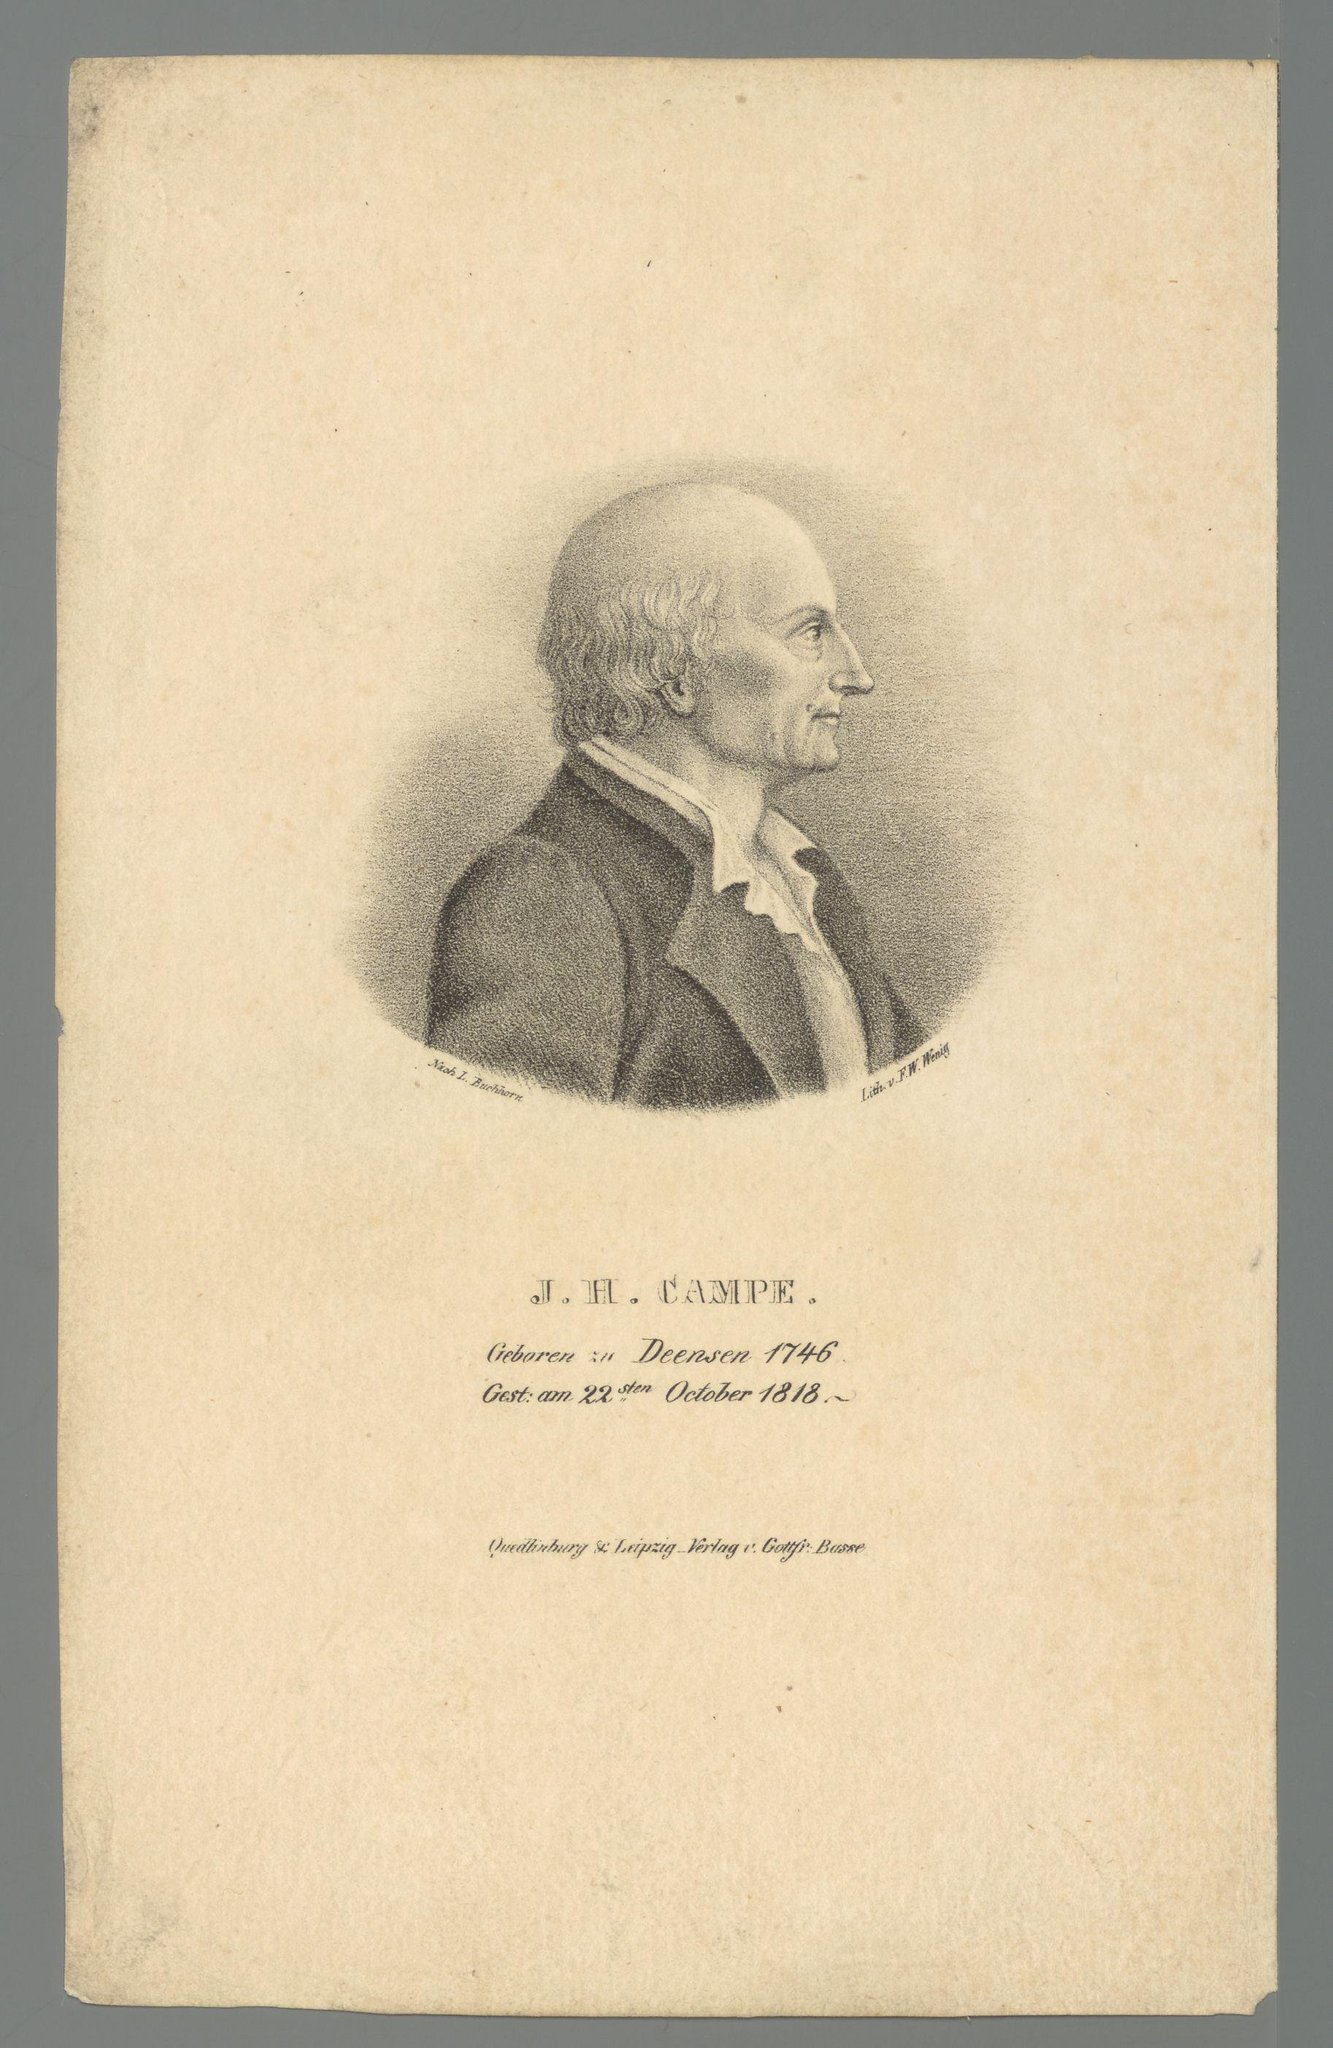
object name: print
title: Portret van Joachim Heinrich Campe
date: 1818-1825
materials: paper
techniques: lithograph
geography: leipzig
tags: joachim heinrich campe, historical persons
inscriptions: collector's mark: Lugt 2228